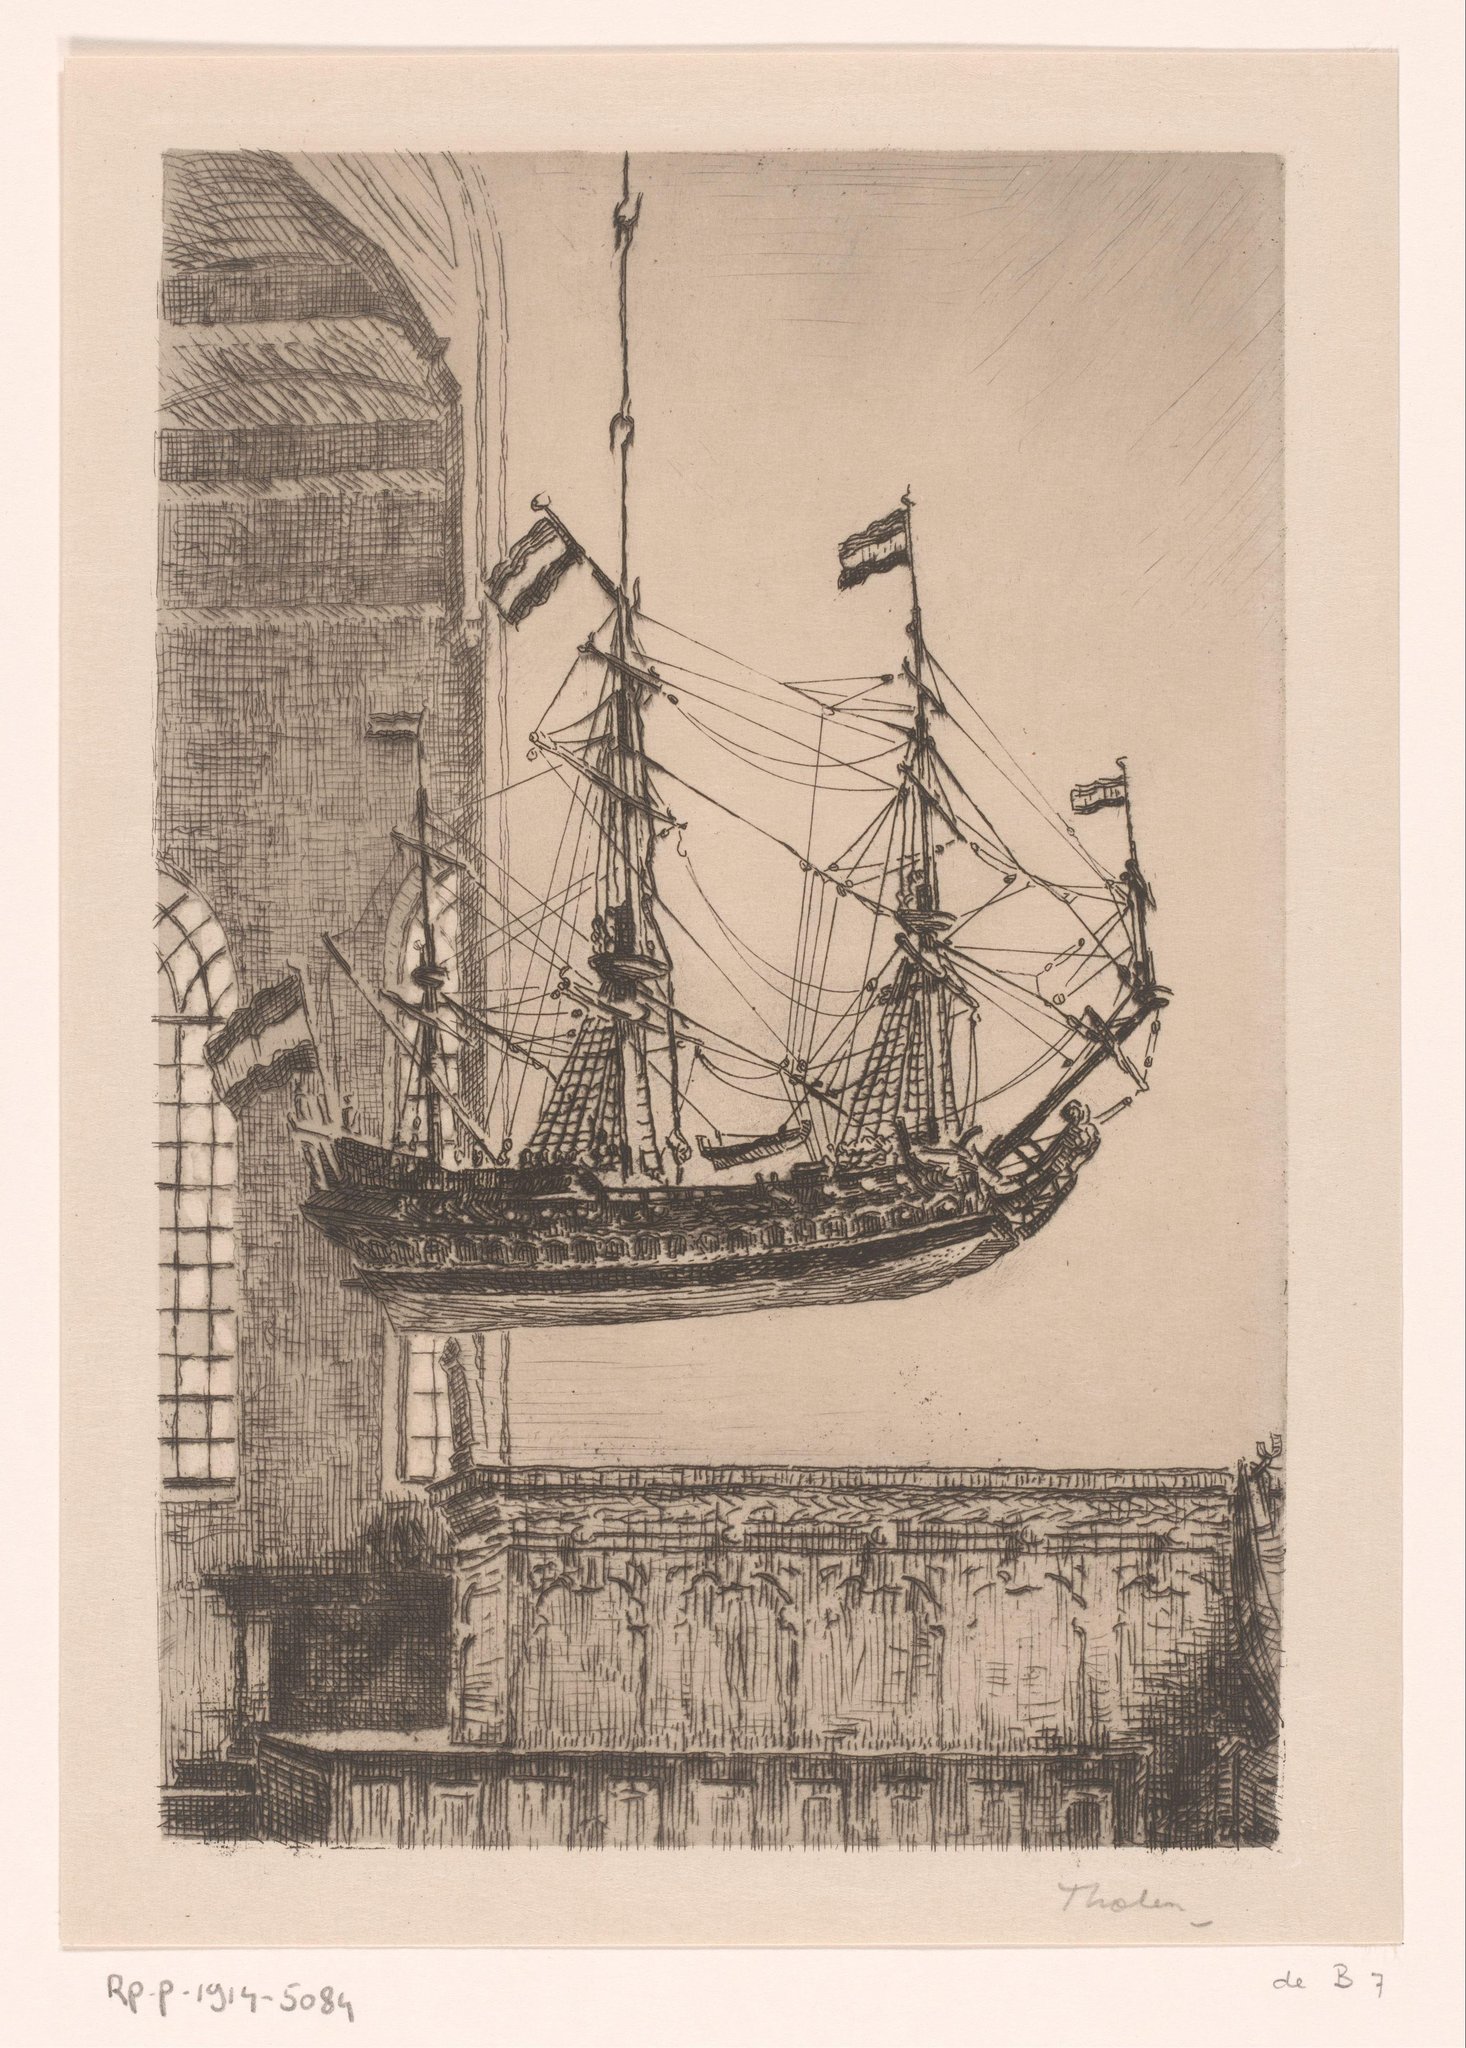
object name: print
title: Scheepsmodel in de Grote Kerk, te Blokzijl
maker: willem bastiaan tholen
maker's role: draughtsman, painter, print maker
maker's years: 1860-1931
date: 1870-1914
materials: paper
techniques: etching, intaglio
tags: interior of church, ship-model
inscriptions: collector's mark: Lugt 2233